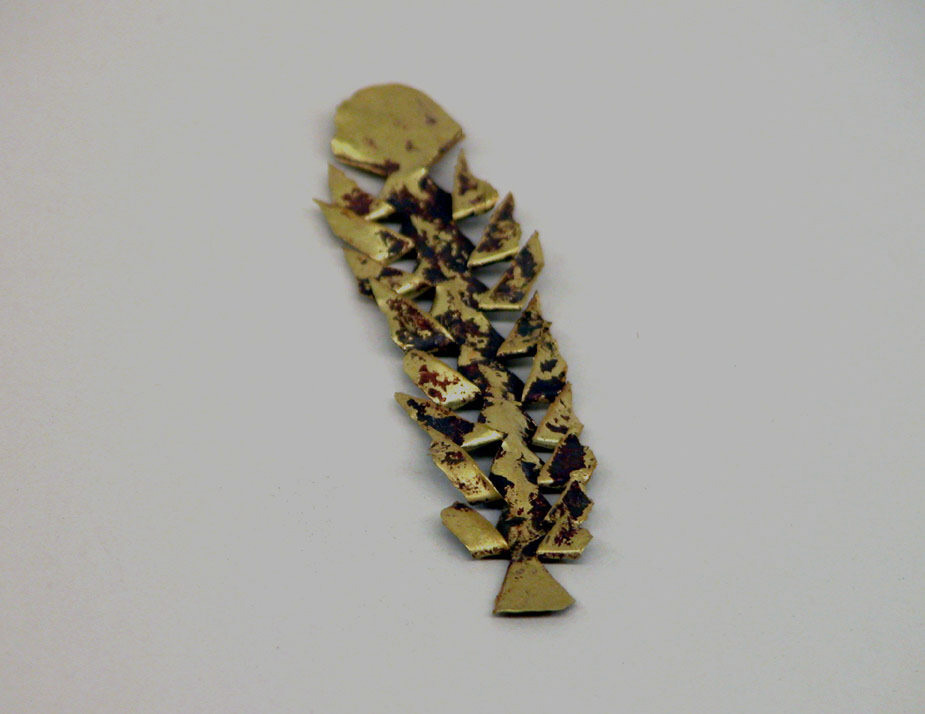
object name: ornament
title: Plaited Ornament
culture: indonesian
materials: gold